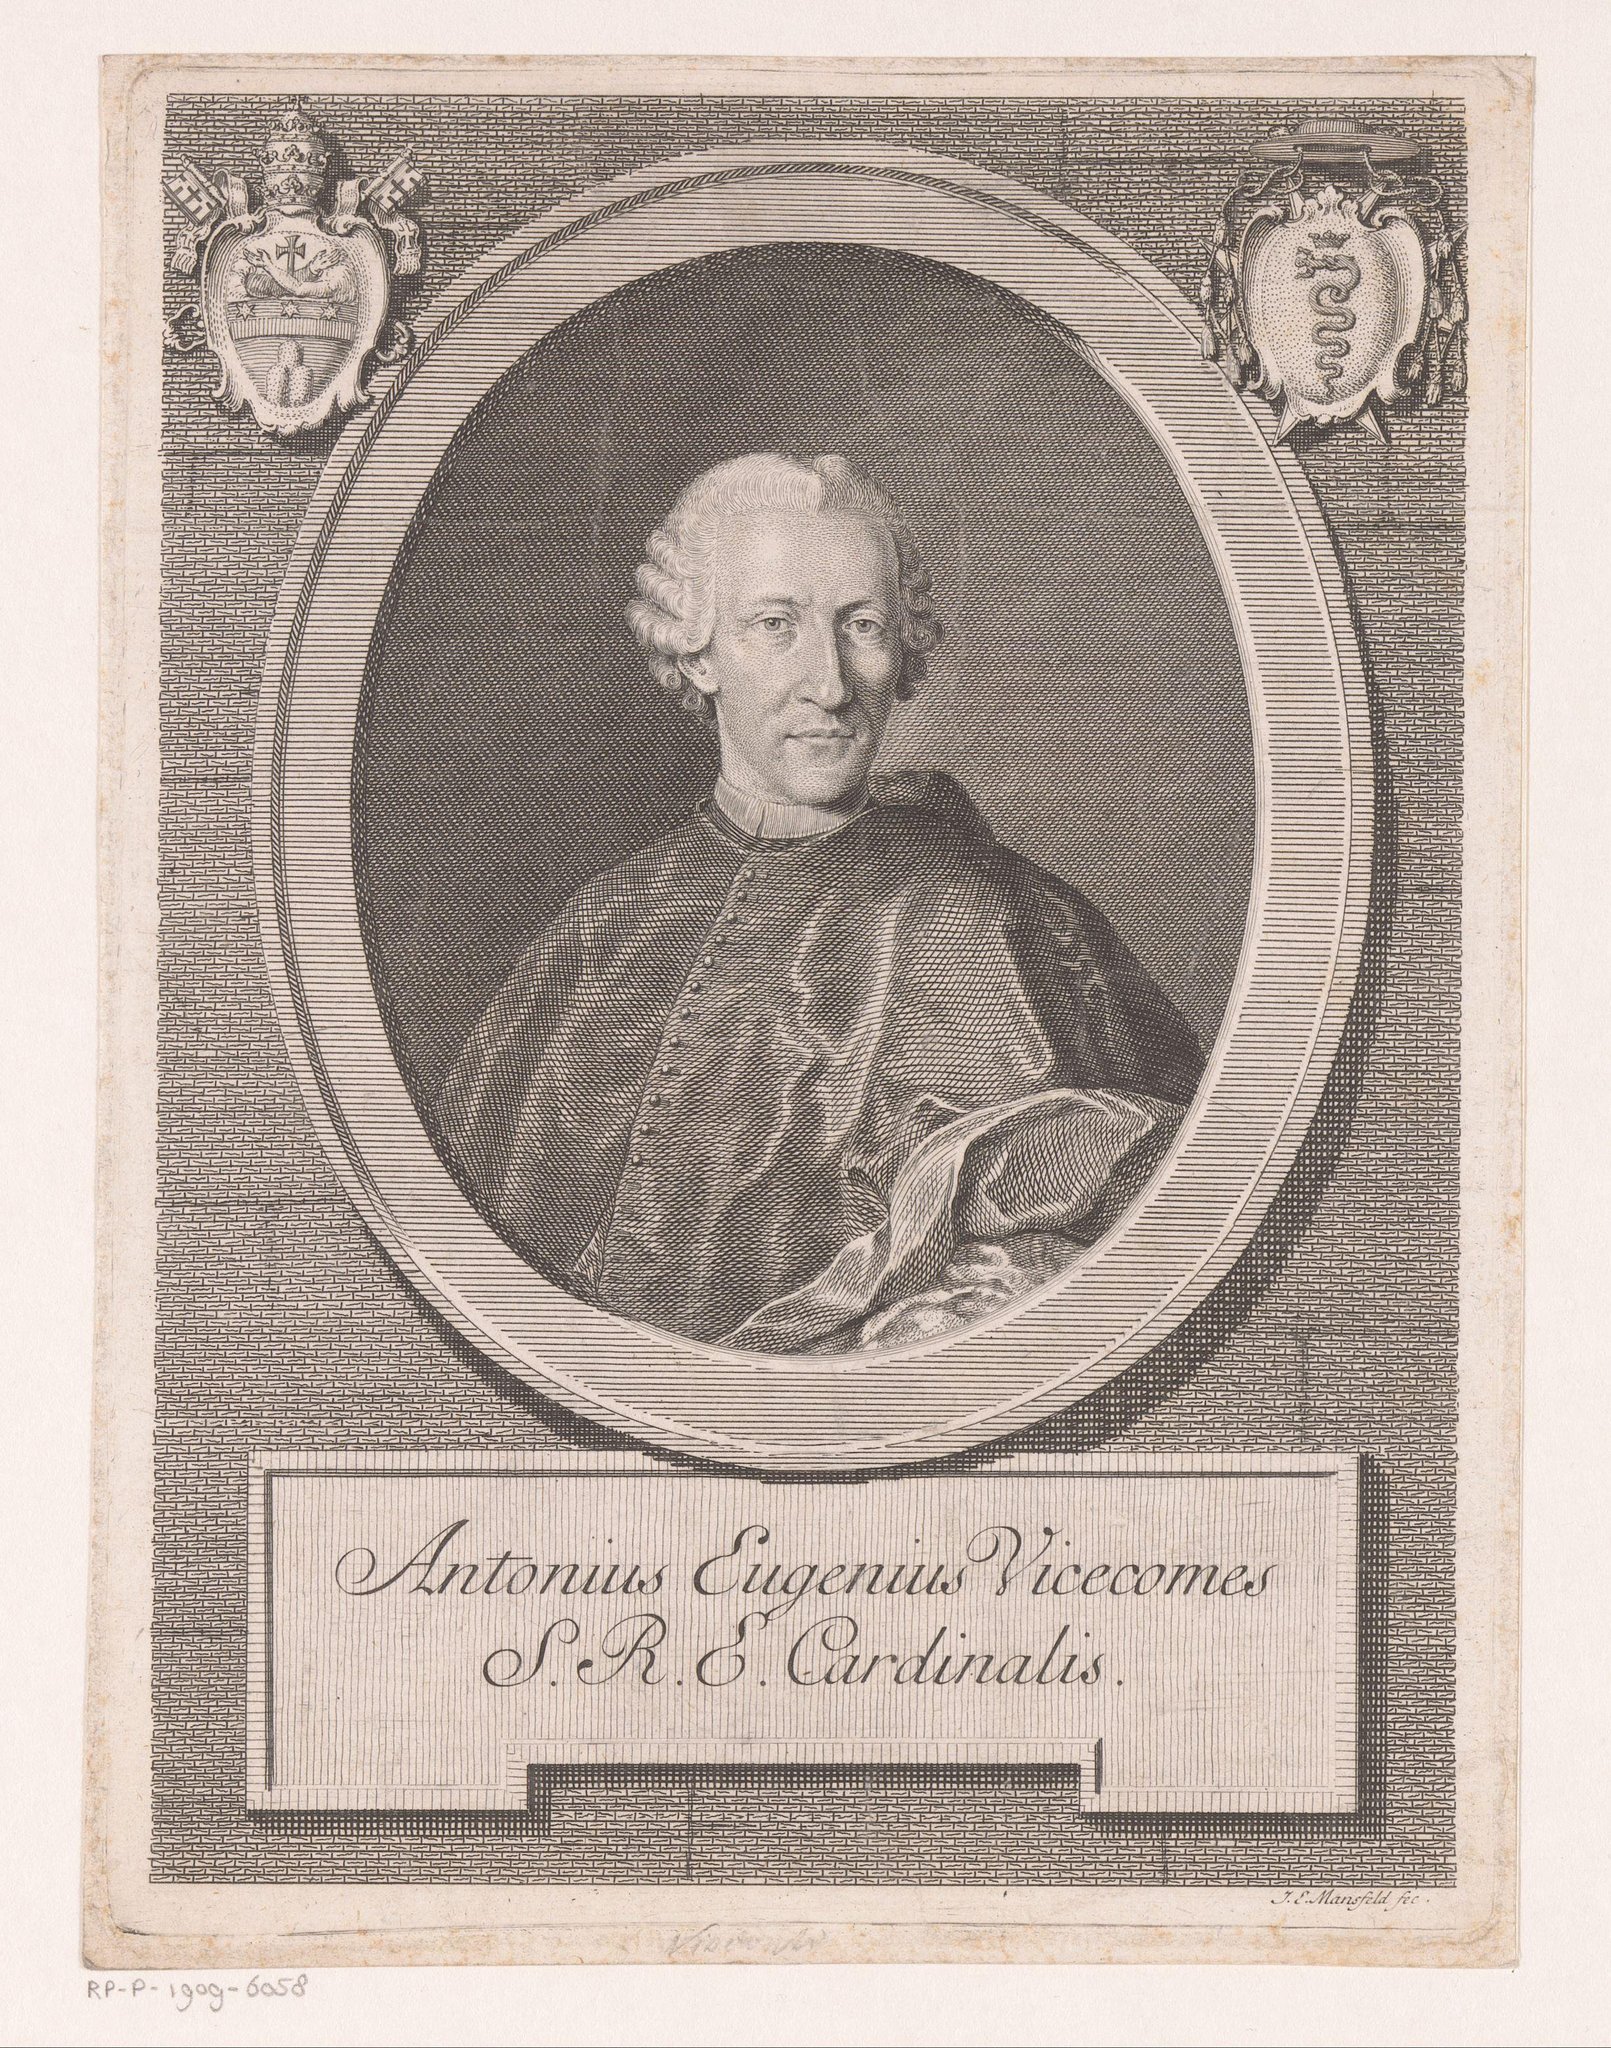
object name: print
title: Portret van Antonio Eugenio Visconti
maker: johann ernst mansfeld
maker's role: print maker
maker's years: 1739-1796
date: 1771-1796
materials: paper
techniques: engraving, etching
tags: coat of arms (as symbol of the state, etc.), cardinal, historical persons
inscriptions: collector's mark: Lugt 2228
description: Portret van kardinaal Antonio Eugenio Visconti. Linksboven het wapen van paus Clemens XIV.